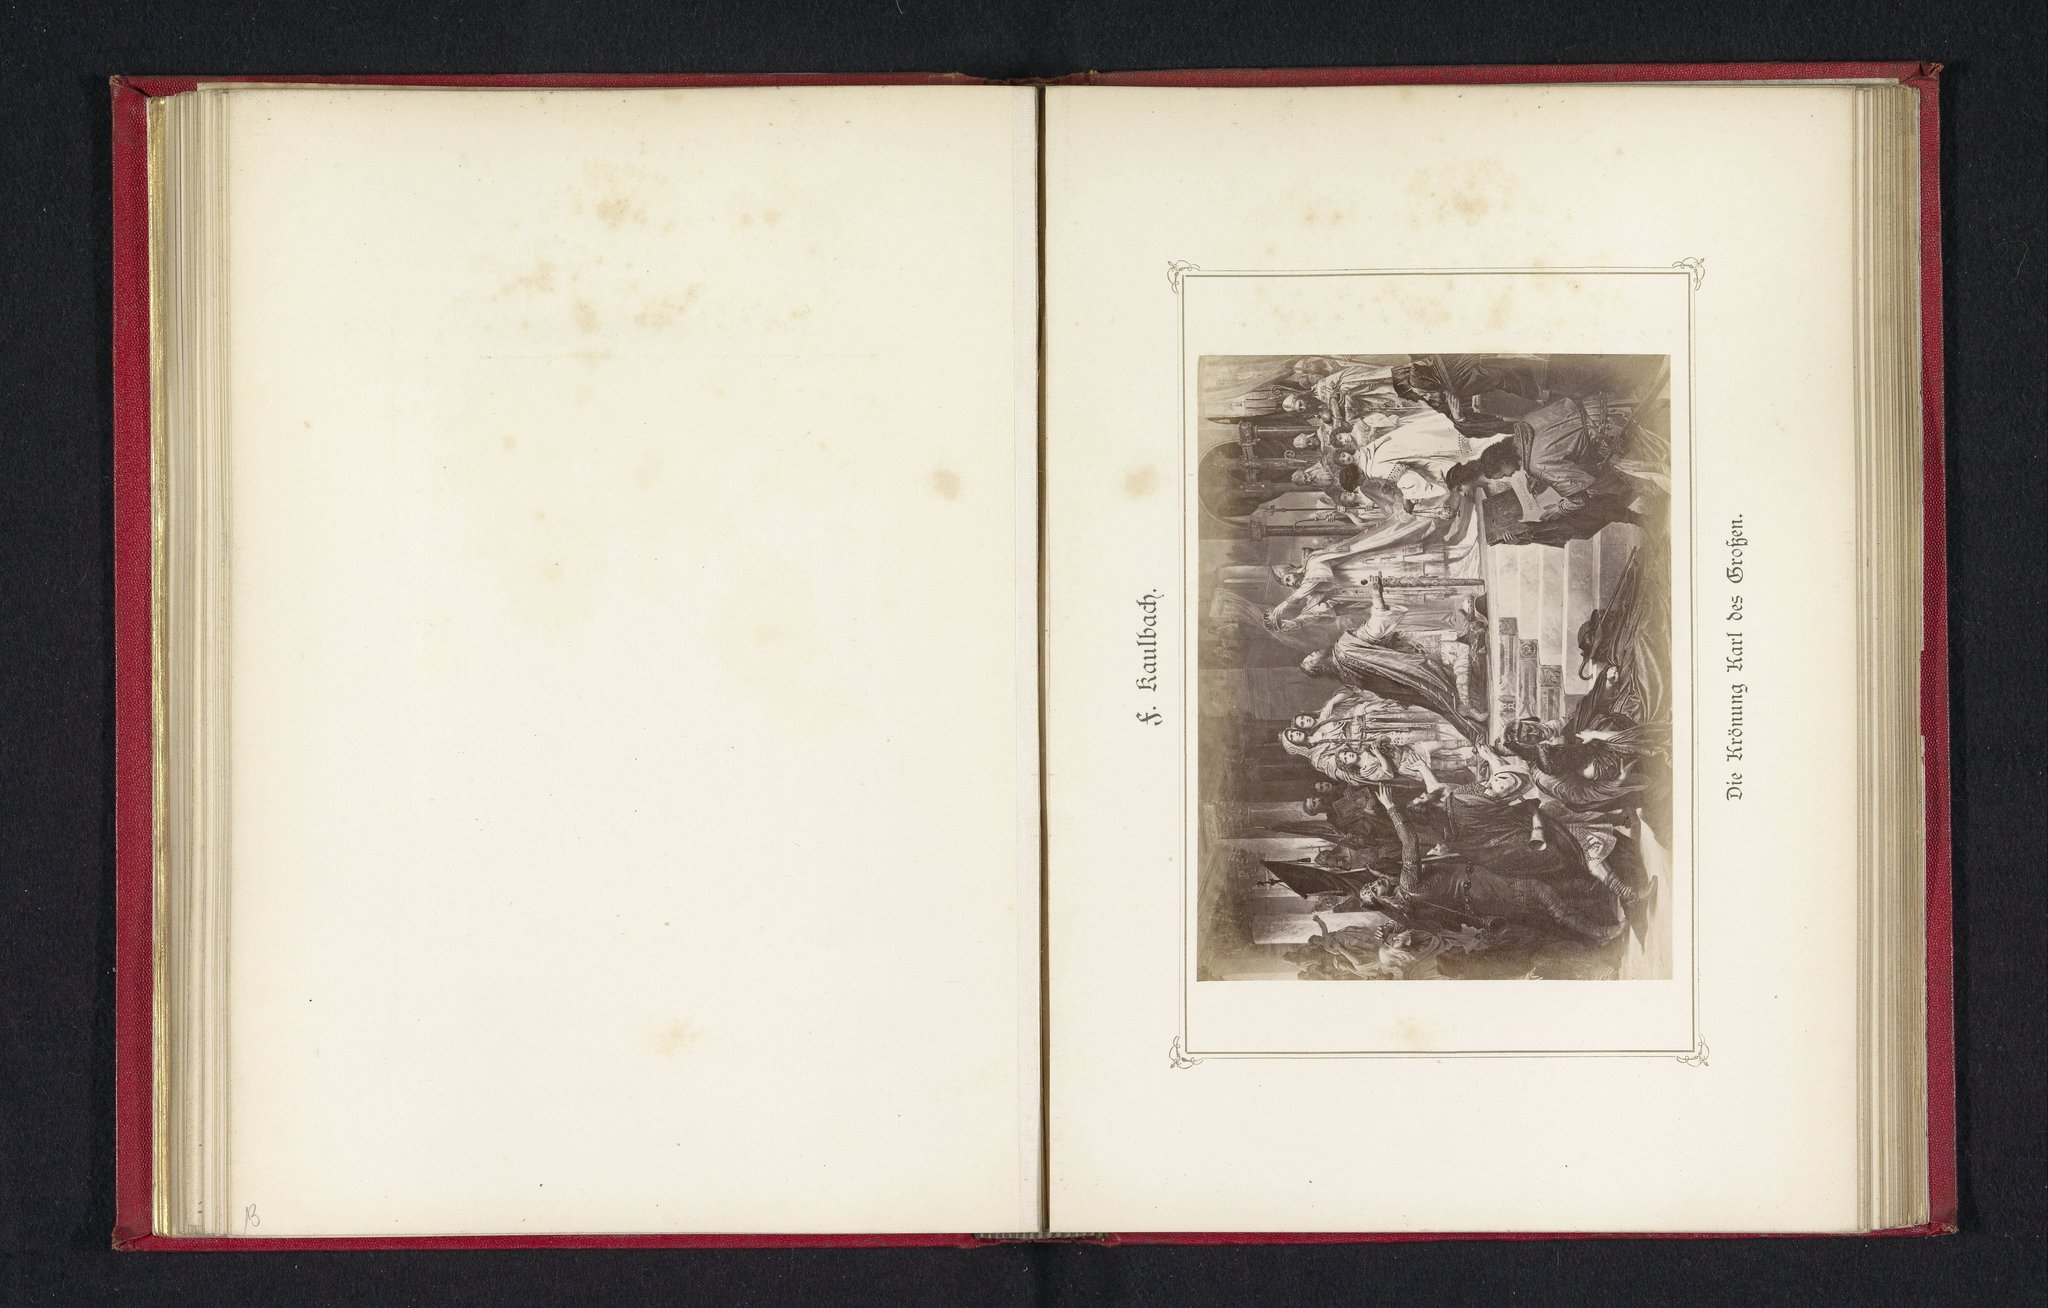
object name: photograph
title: Die Krönung Karl des Großen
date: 1875-1880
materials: photographic support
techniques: albumen print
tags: coronation of a ruler, the holy roman emperor charlemagne; possible attributes: crown, model of church, orb, sceptre, sword